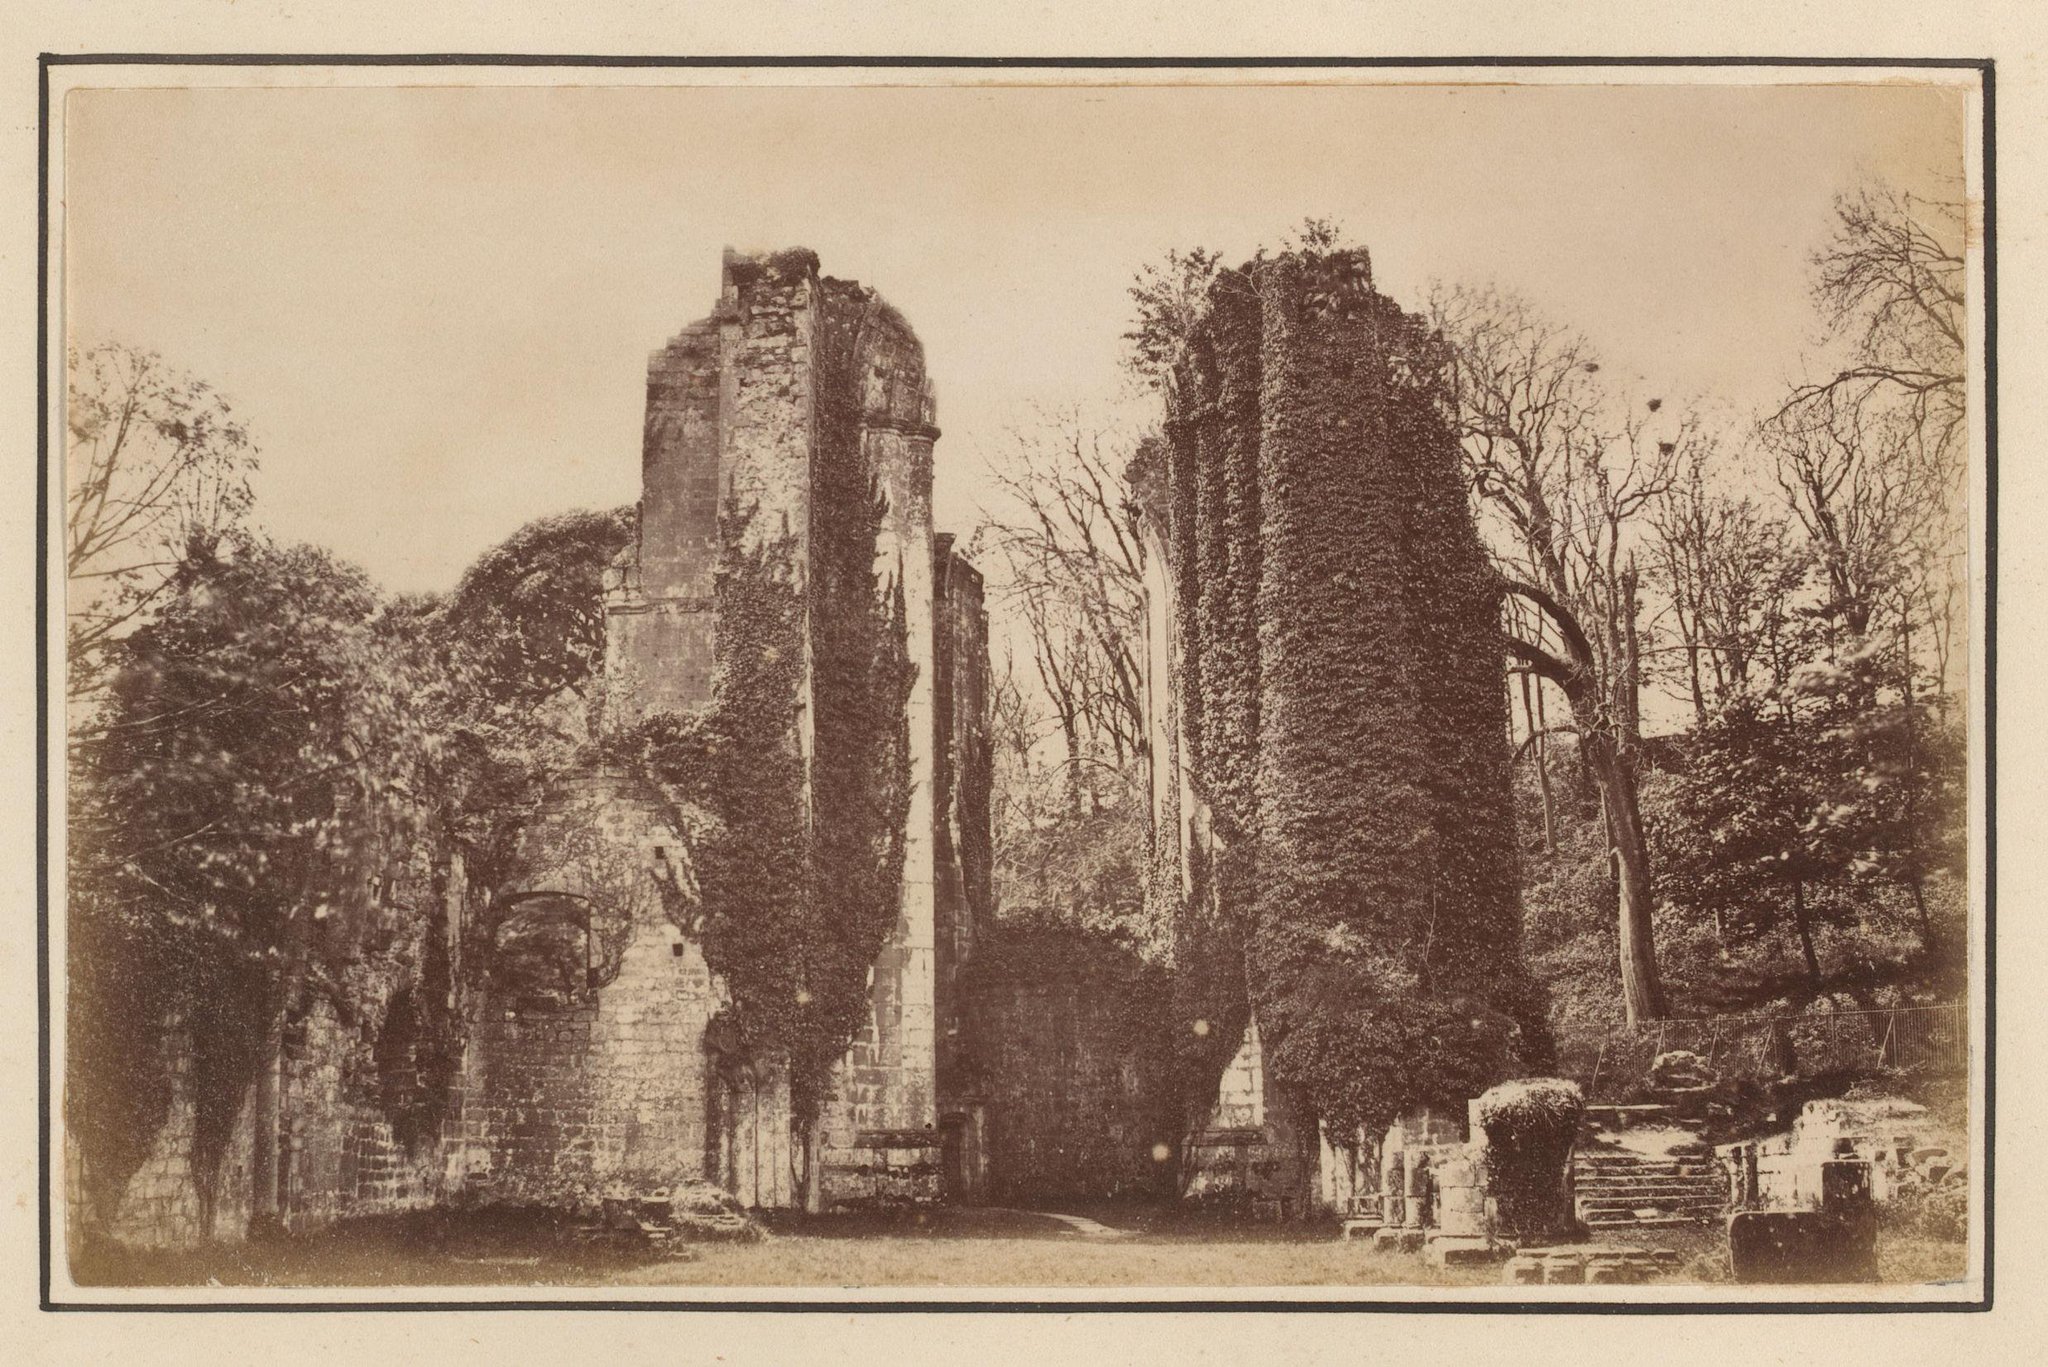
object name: photograph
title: Ruïne van de abdij van Furness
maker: Anonymous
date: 1870-1890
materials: paper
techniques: albumen print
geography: furness abbey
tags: ruin of church, monastery, etc., plants and herbs: ivy